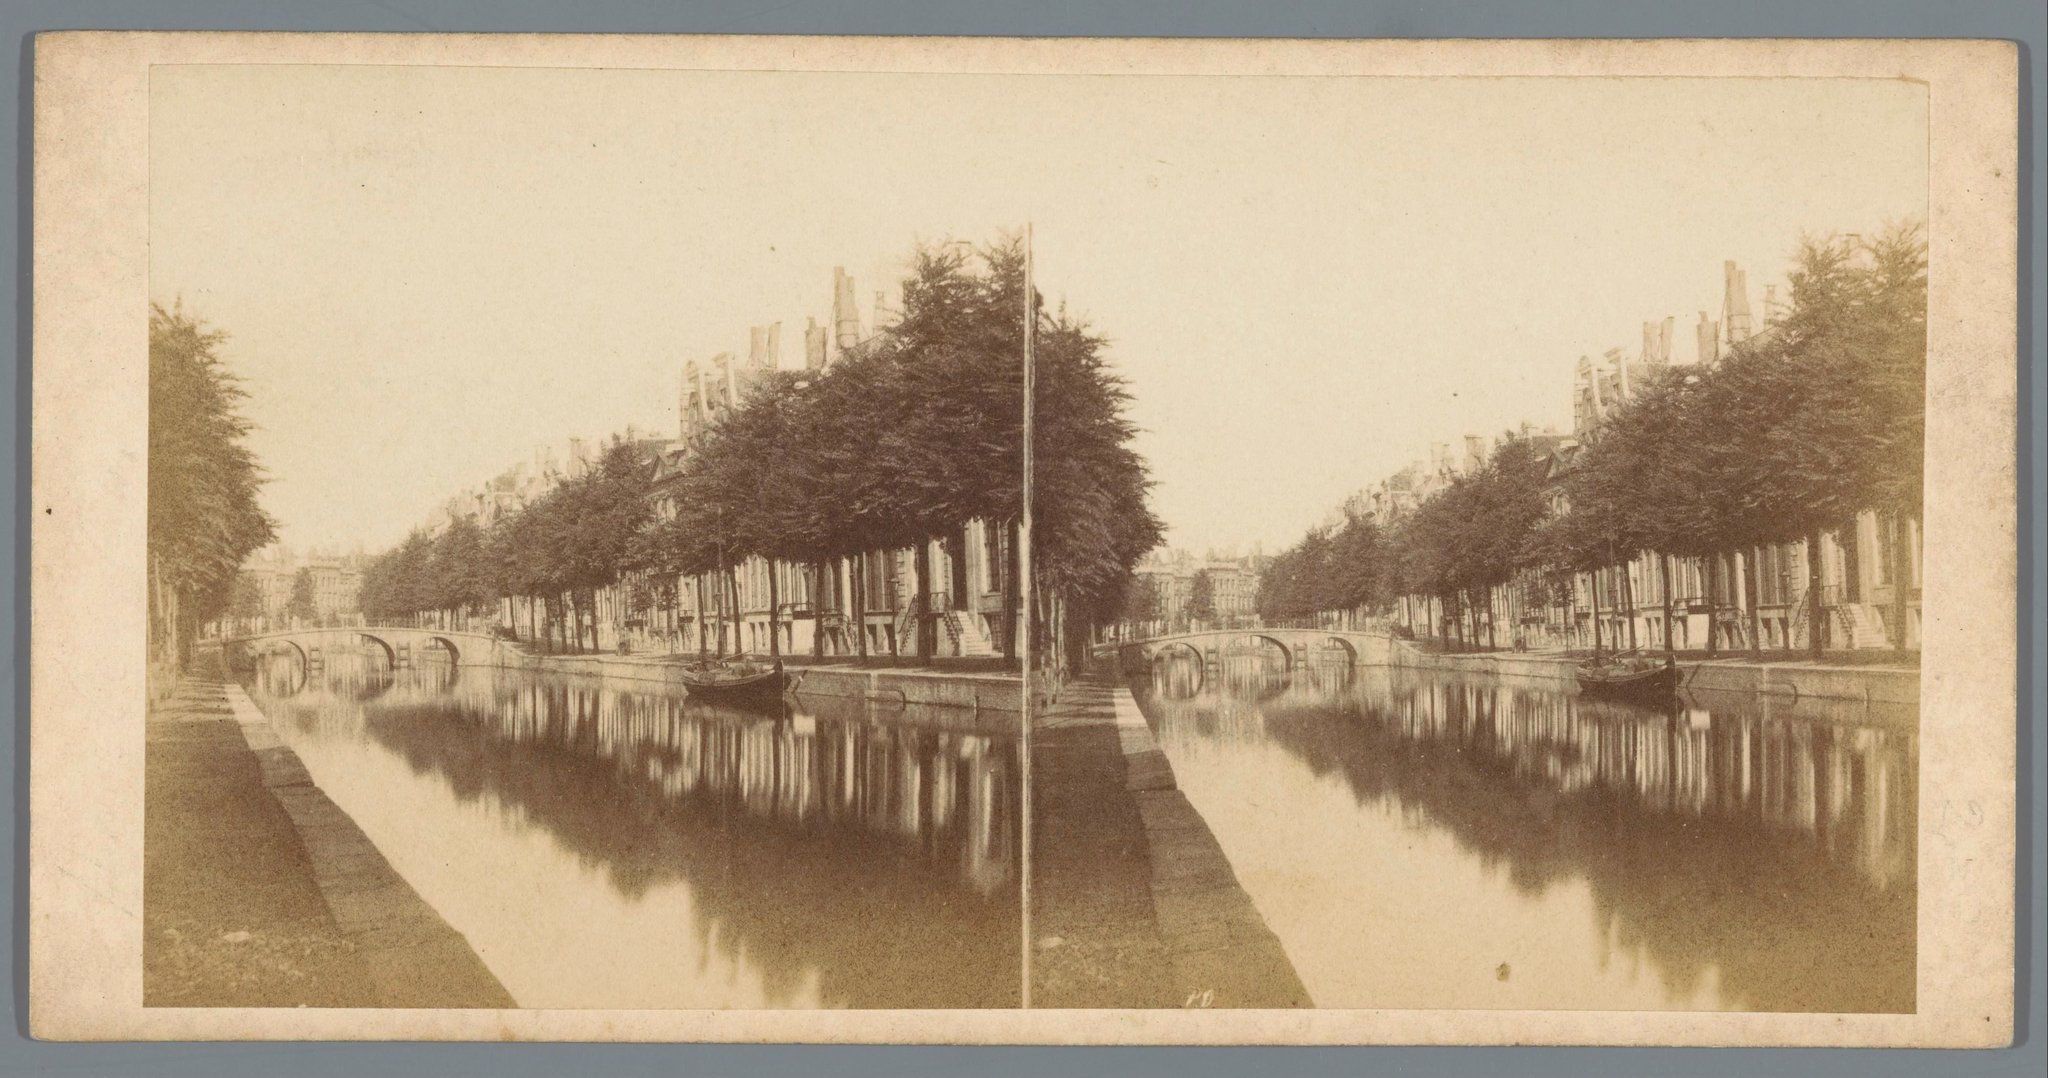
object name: stereograph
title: Herengracht bij de Vijzelstraat, Amsterdam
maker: pieter oosterhuis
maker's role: draughtsman, print maker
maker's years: 1816-1885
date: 1855-1870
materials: cardboard, paper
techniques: albumen print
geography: amsterdam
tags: canals, waters (in city)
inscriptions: number: ‘20.’, number: ‘No. 267.’, initials: ‘P.O.’